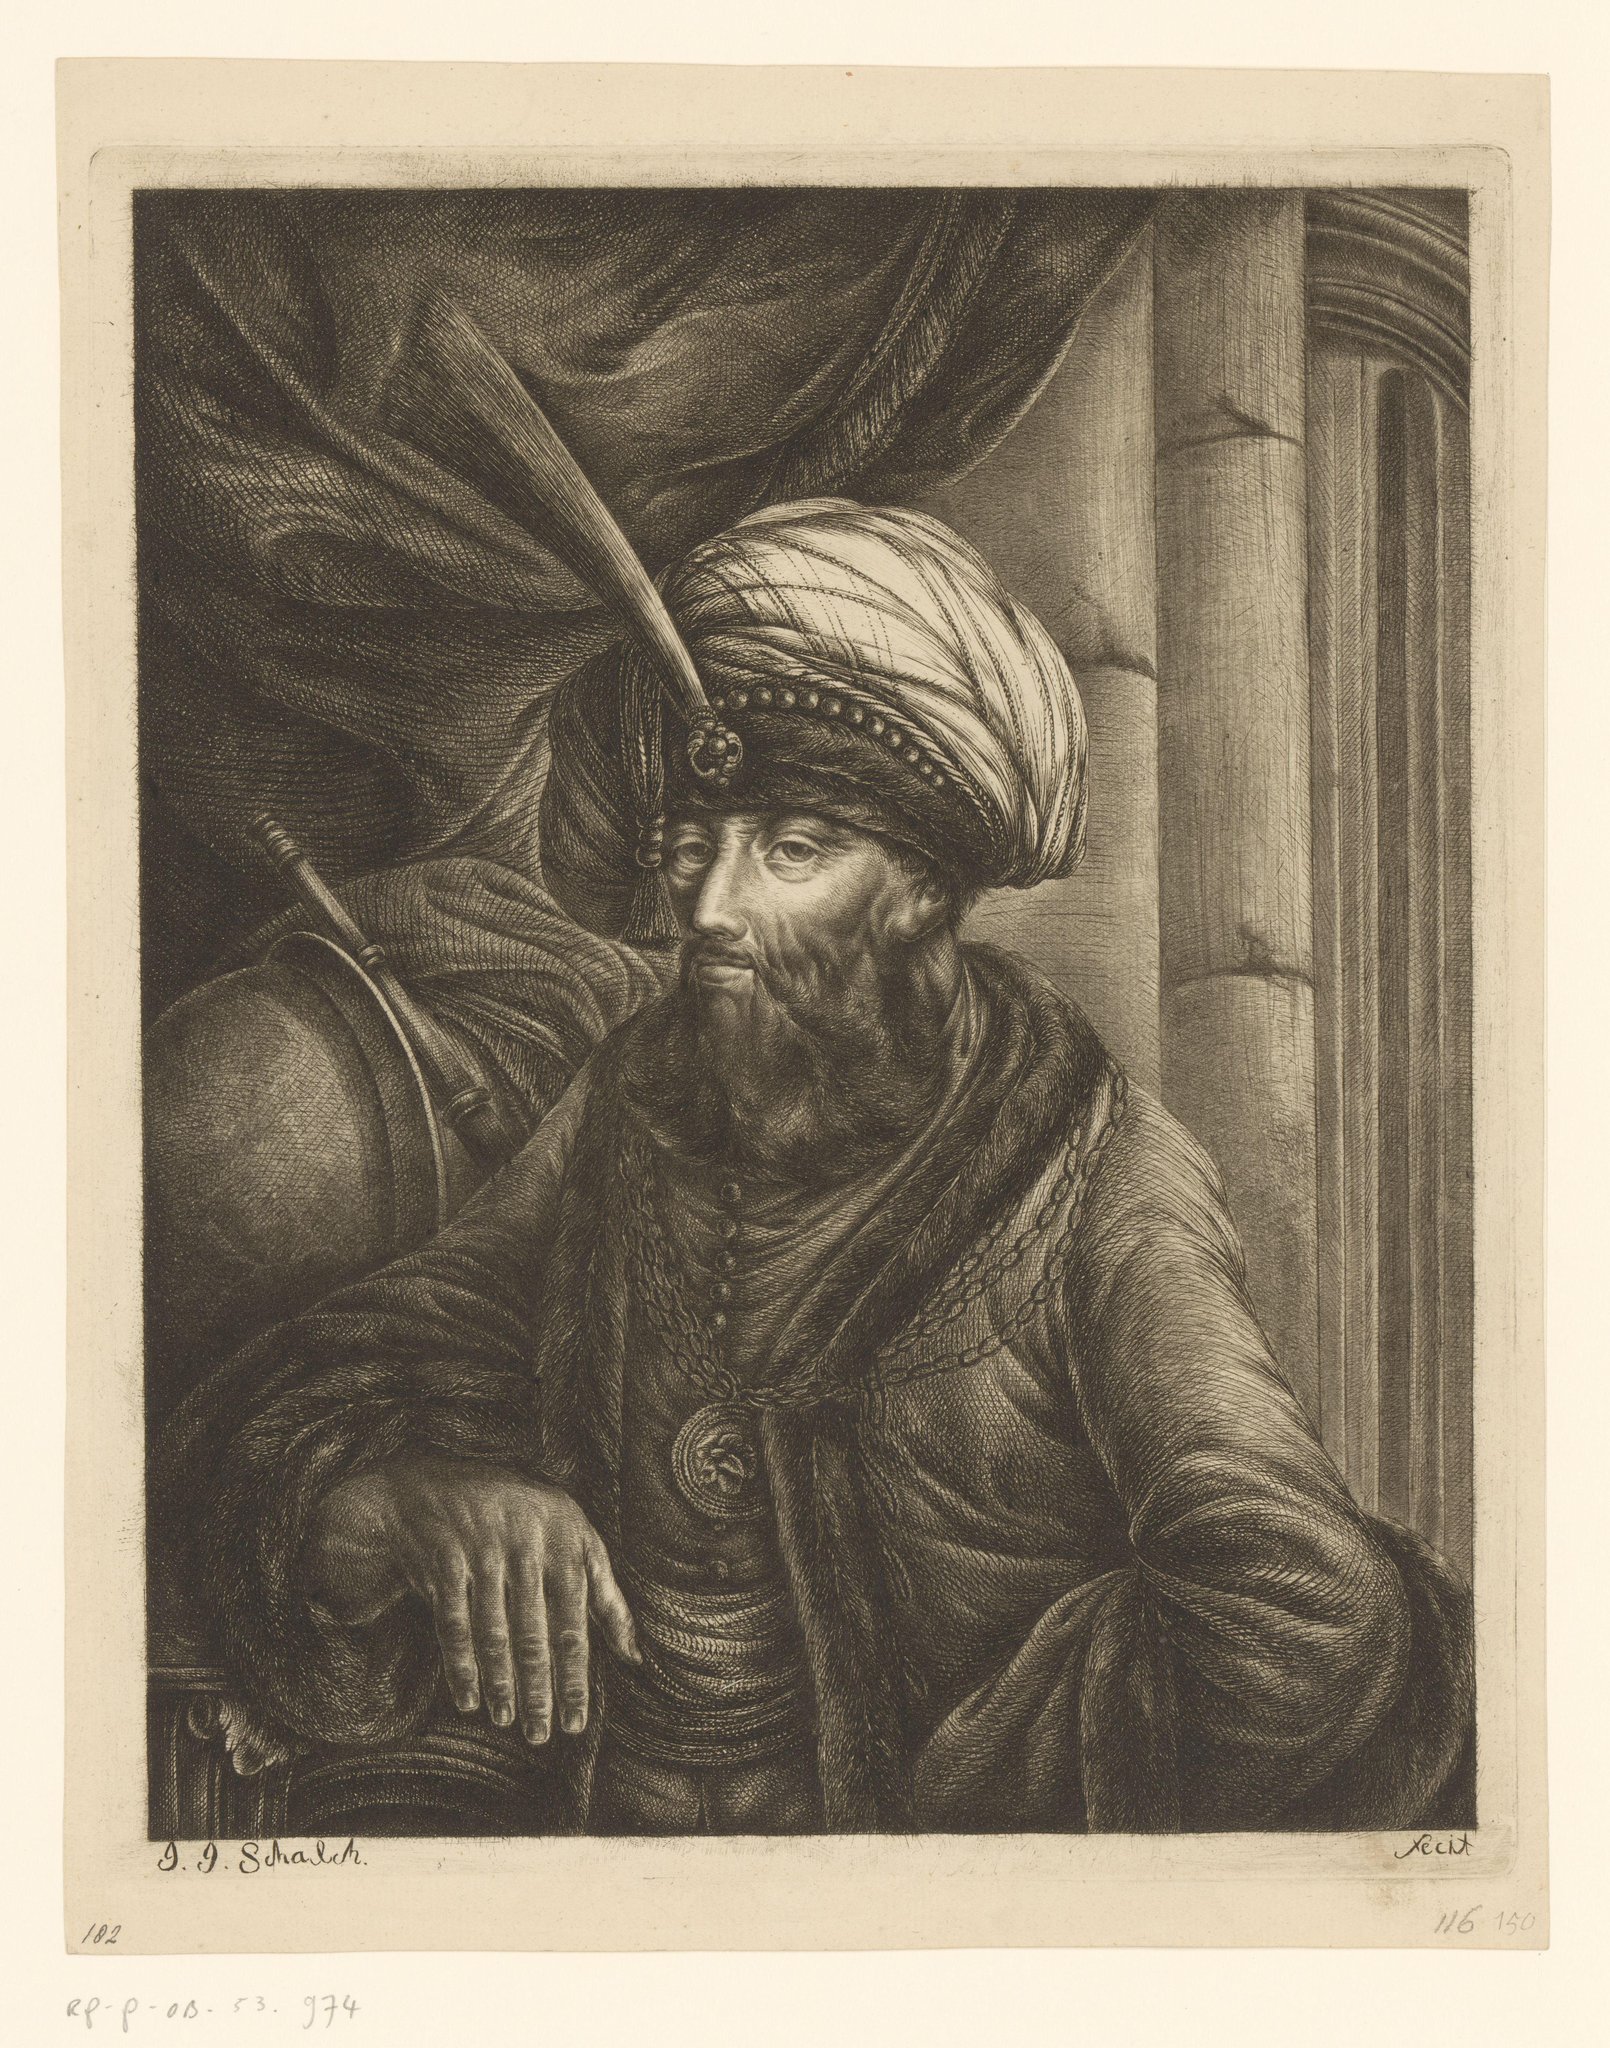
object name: print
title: Buste van man met tulband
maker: johann jakob schalch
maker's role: print maker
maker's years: 1723-1789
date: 1733-1789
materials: paper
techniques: etching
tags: historical persons, head-gear: turban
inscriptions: collector's mark: Lugt 240